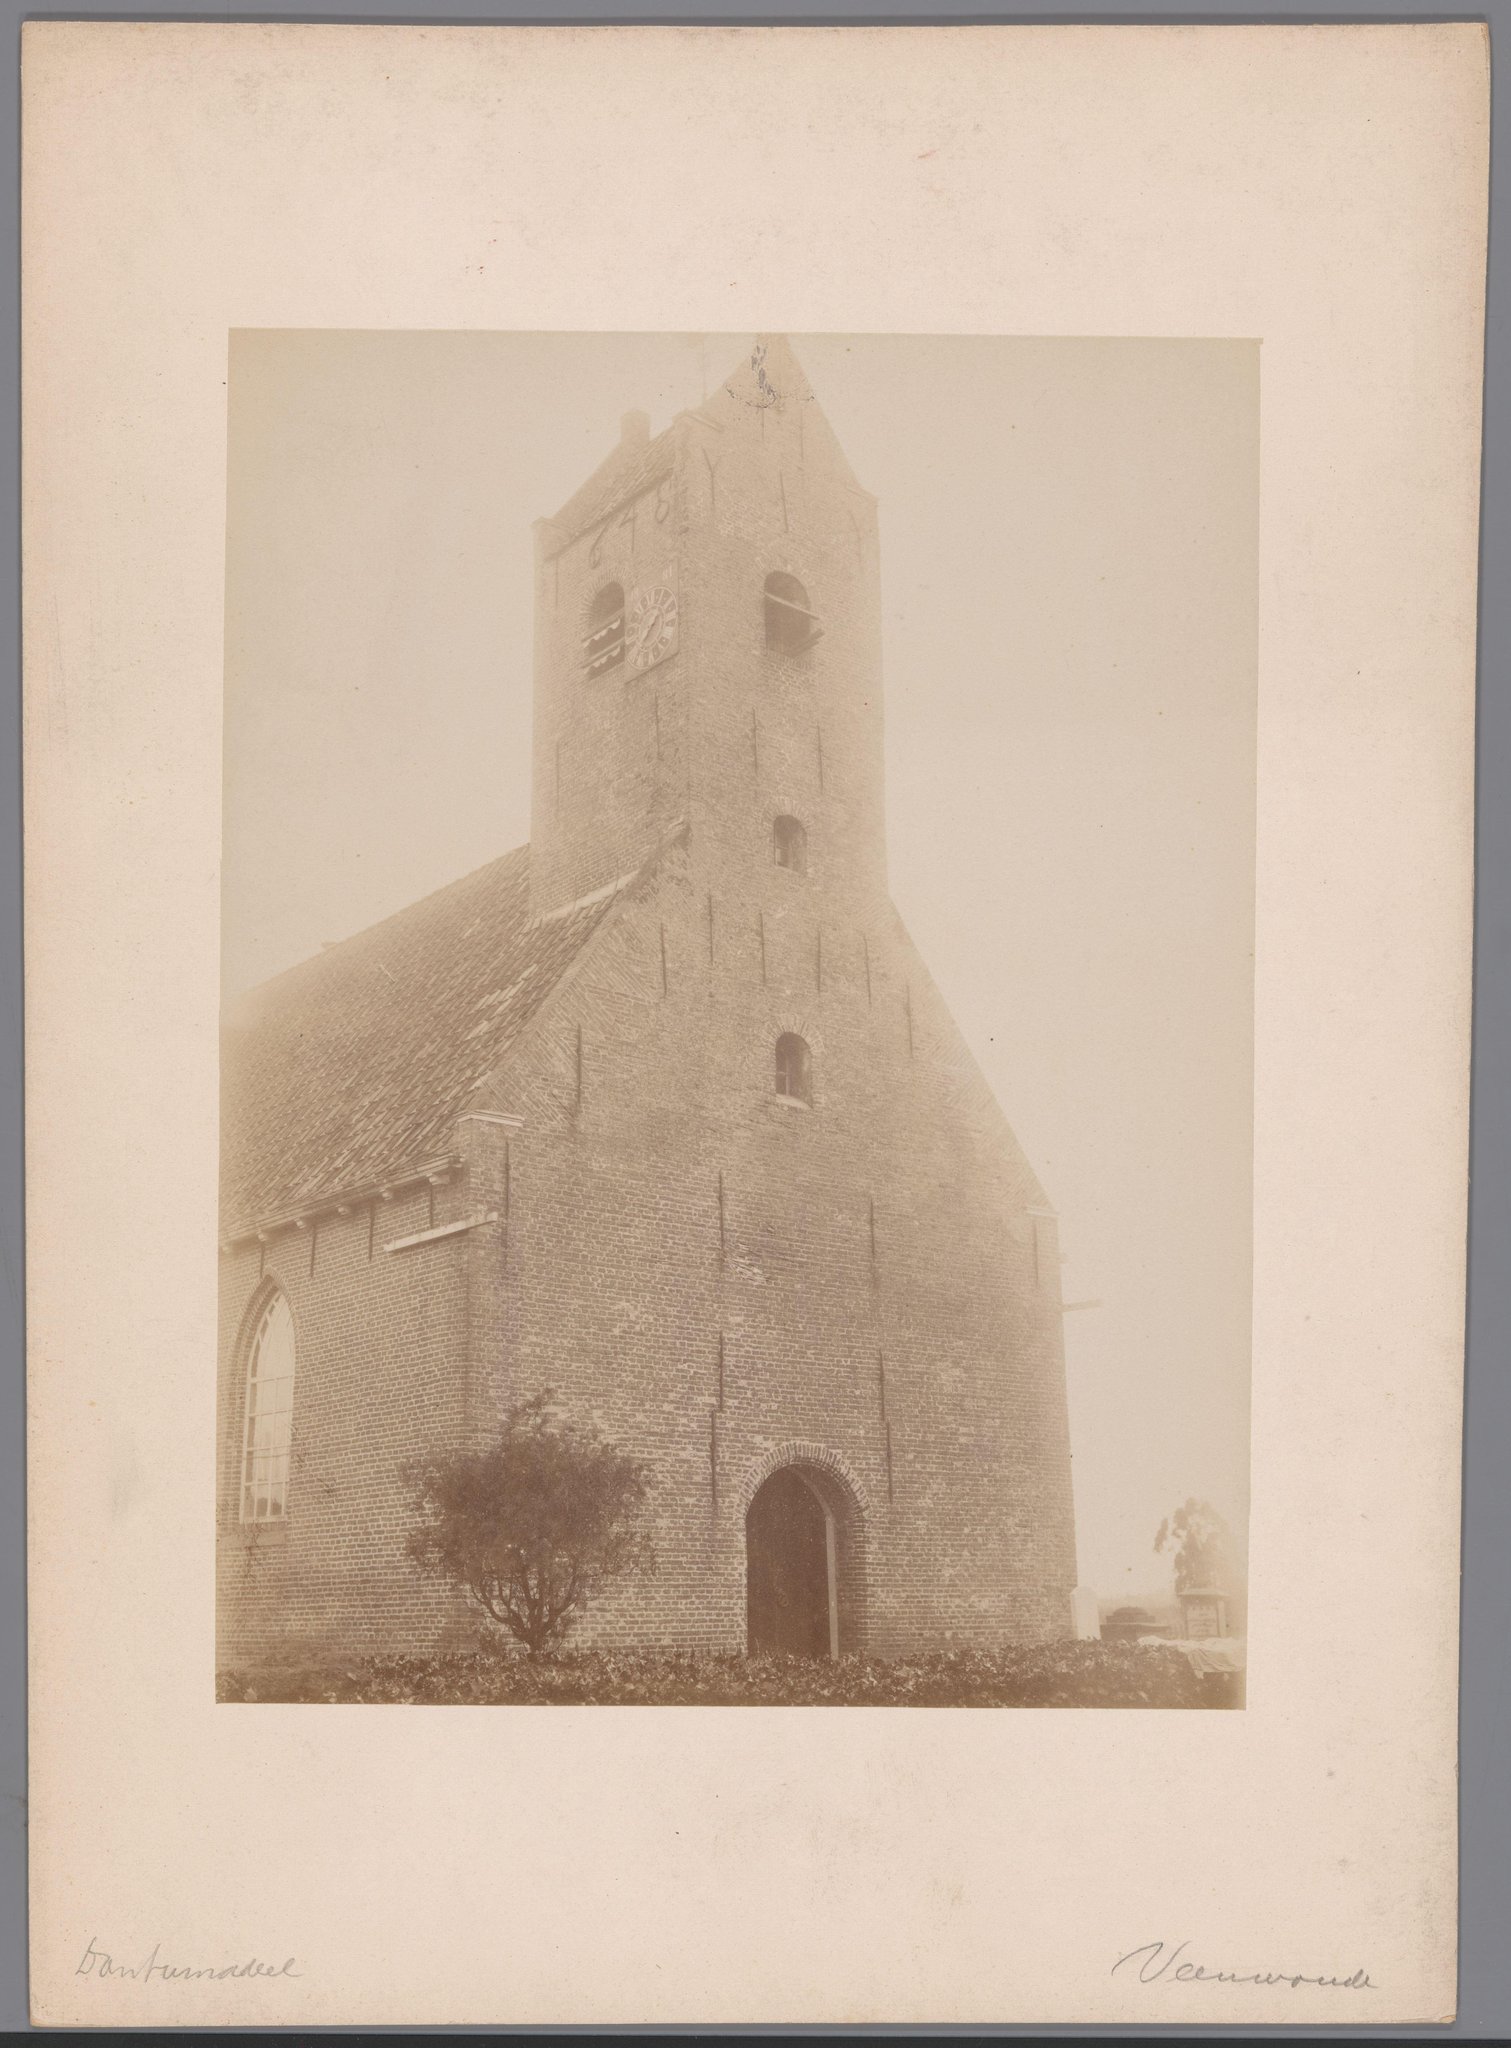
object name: photograph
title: Gezicht op de Johanneskerk te Veenwouden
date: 1903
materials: cardboard, photographic support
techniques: albumen print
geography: veenwouden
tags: church (exterior)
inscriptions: annotation: ‘Dantumadeel/ Veenwouden’, annotation: ‘Veenwouden (Fr) / Toren N.H. kerk / Nov 1903’